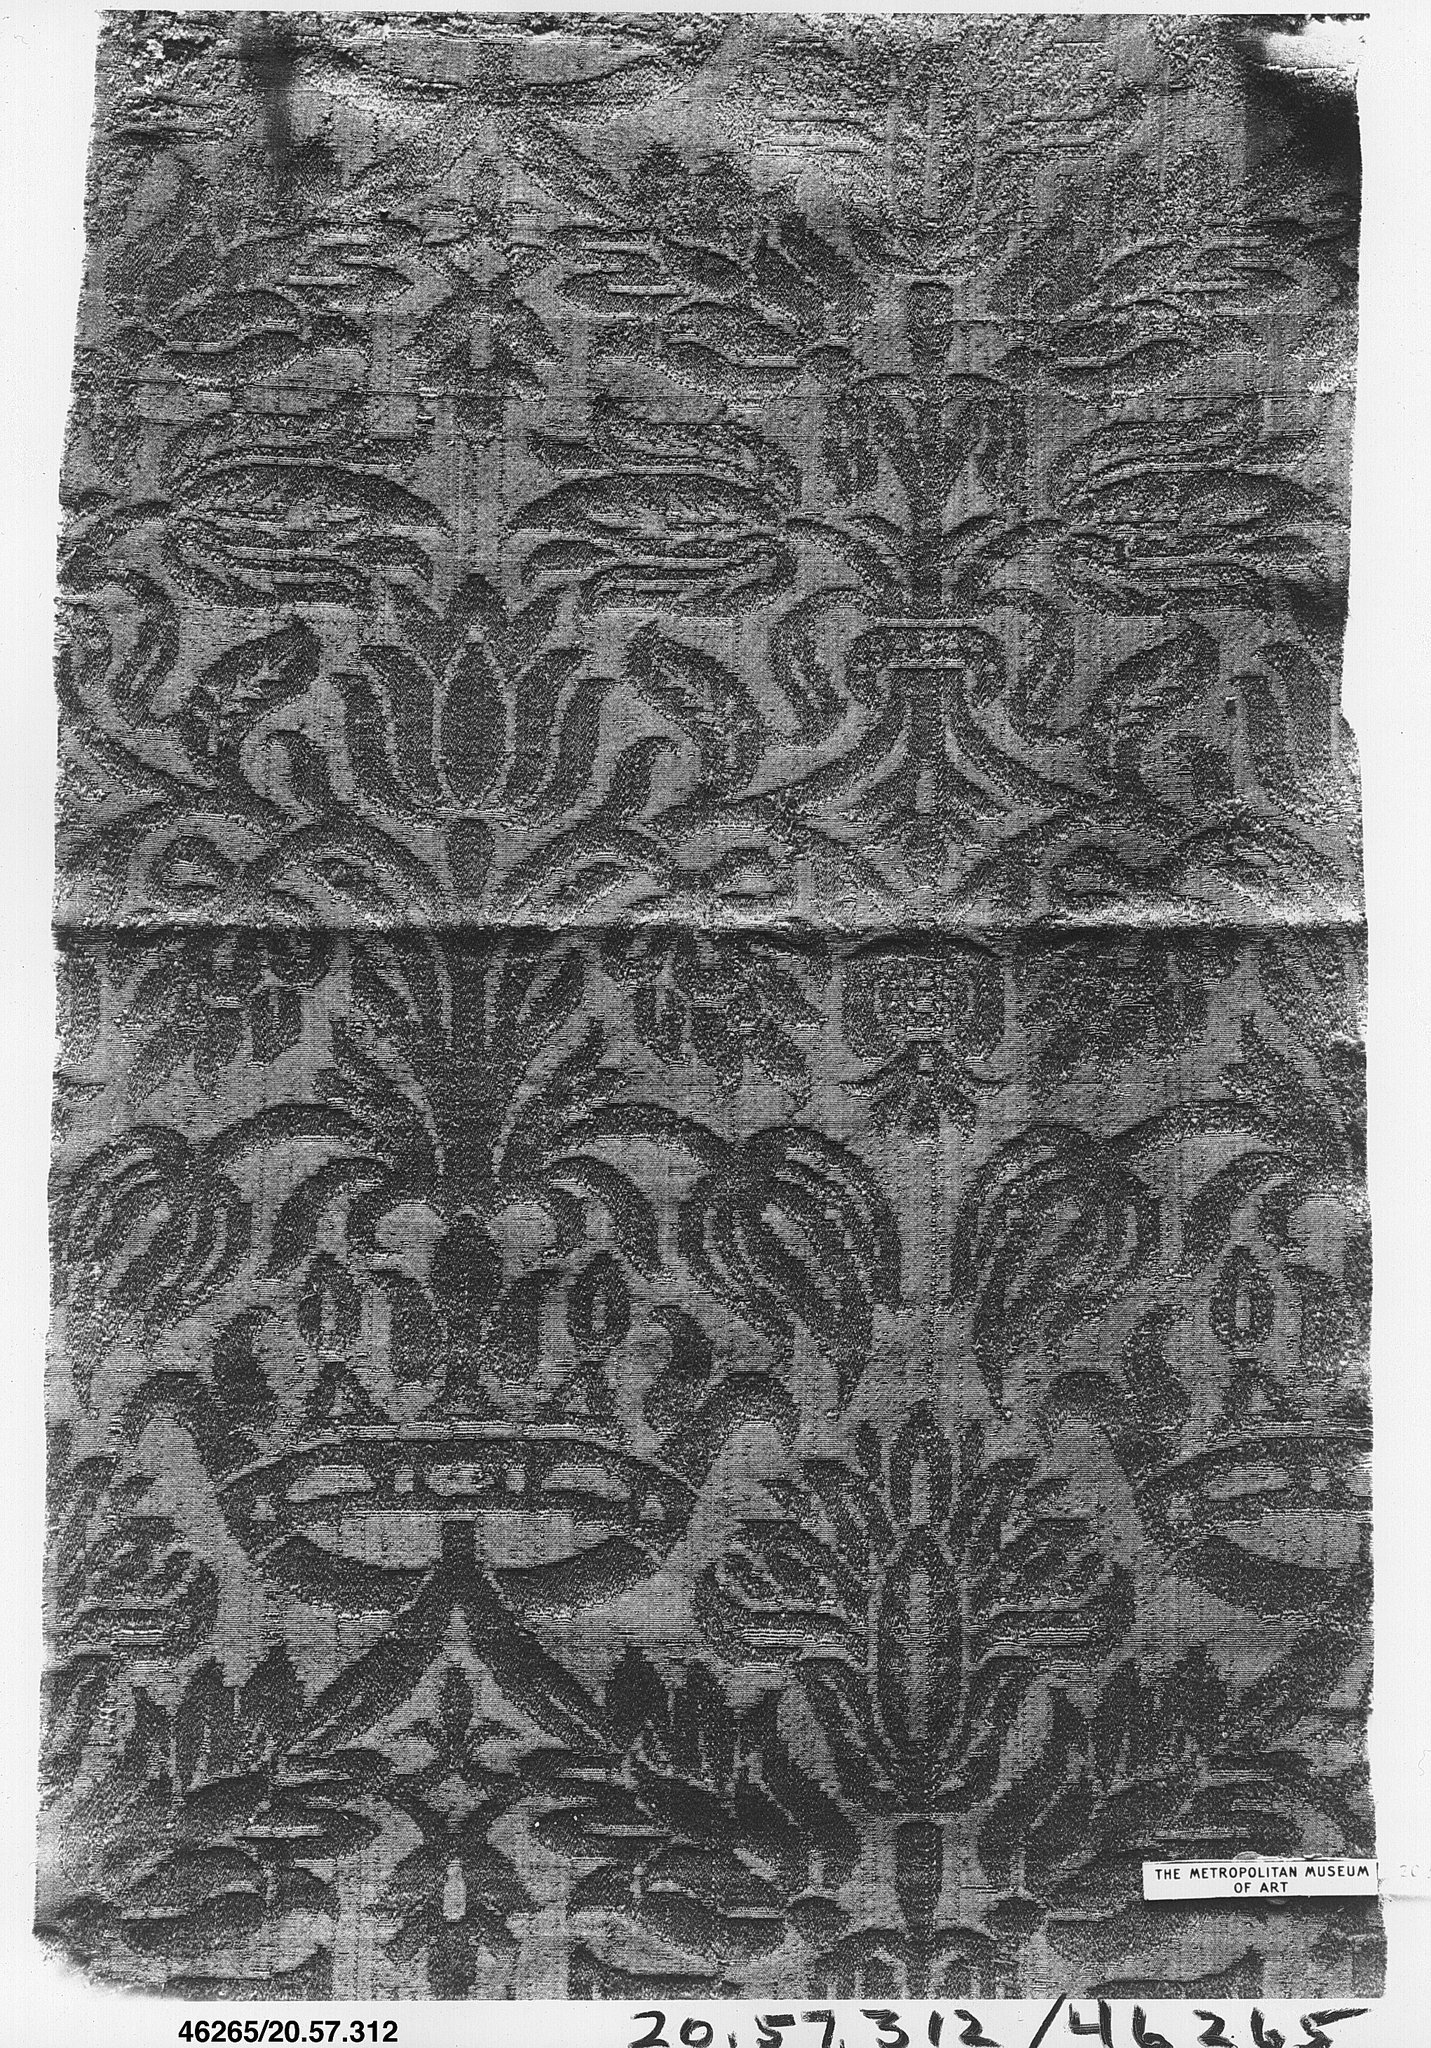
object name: piece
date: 1601-1700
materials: silk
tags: flowers,leaves